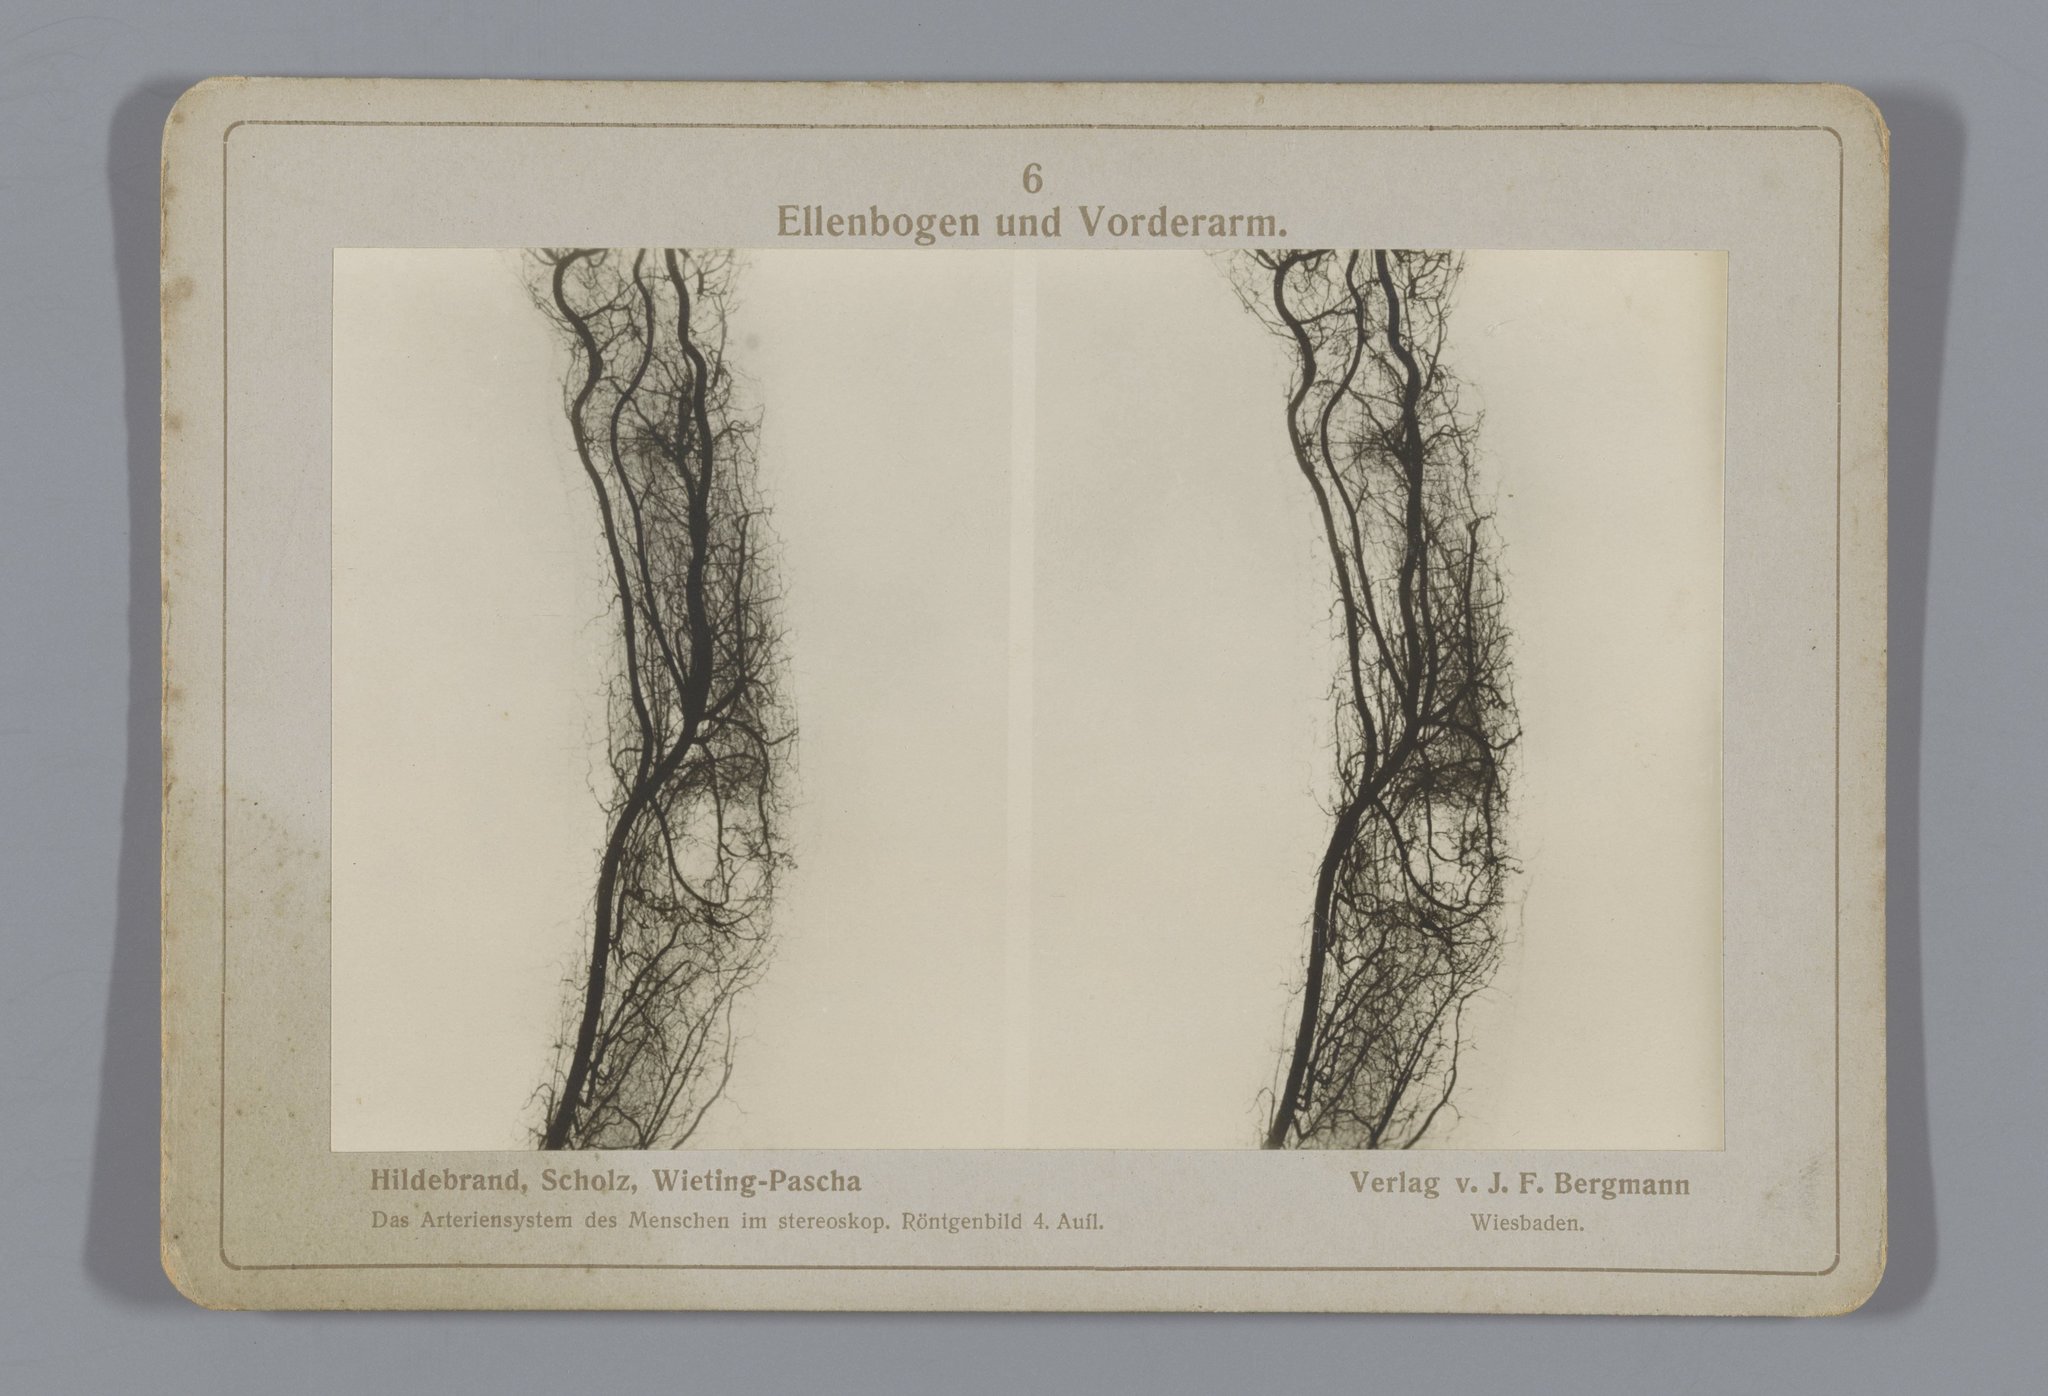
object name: stereograph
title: Röntgenopname van bloedvaten in de elleboog en onderarm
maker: joseph friedrich bergmann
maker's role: publisher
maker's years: 1849-1917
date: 1917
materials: paper, cardboard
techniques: gelatin silver print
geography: wiesbaden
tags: arteries, physiology and anatomy ~ circulatory system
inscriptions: number: ‘6’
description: Foto afkomstig uit: Hildebrand, O., W. Scholz en J. Wieting. Das Arteriensystem des Menschen im stereoskopischen Röntgenbild, Sammlung von stereoskopischen Röntgenbildern aus dem Neuen Allgemeinen Krankenhaus Hamburg-Eppendorf. 4de druk. Wiesbaden: J.F. Bergmann, 1917.